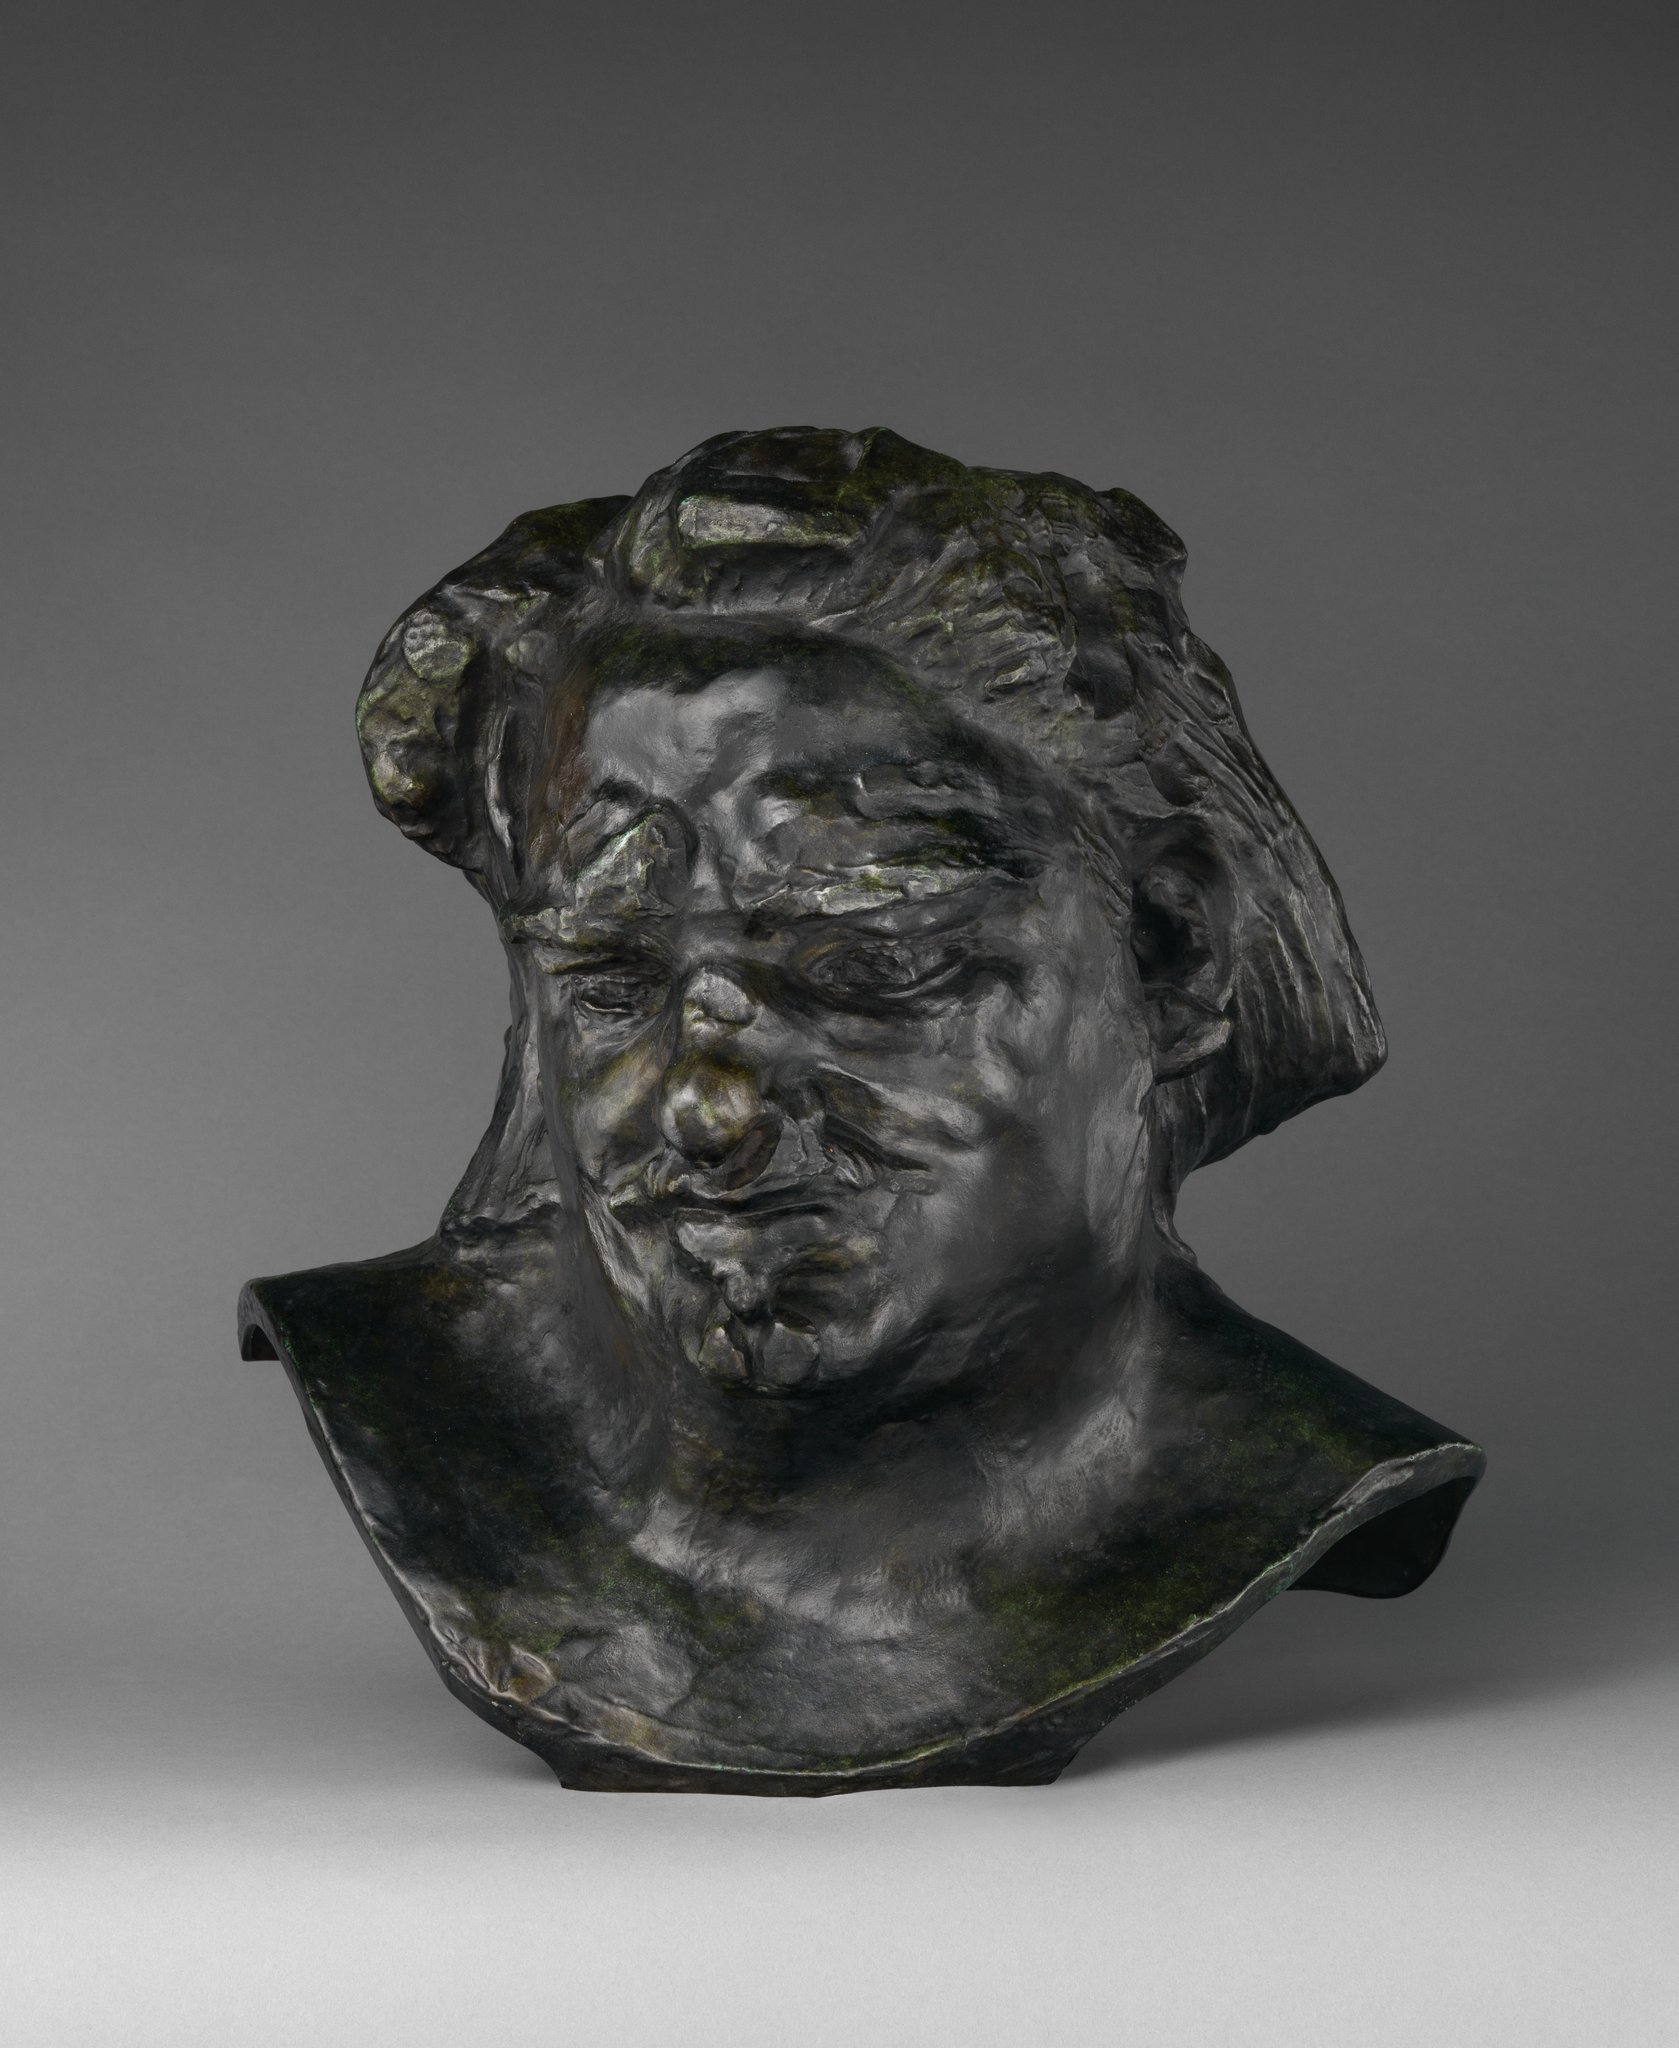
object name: bust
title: Head of Balzac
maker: auguste rodin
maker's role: artist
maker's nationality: french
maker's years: 1840-1917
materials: bronze, marble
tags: faces,heads,men,portraits